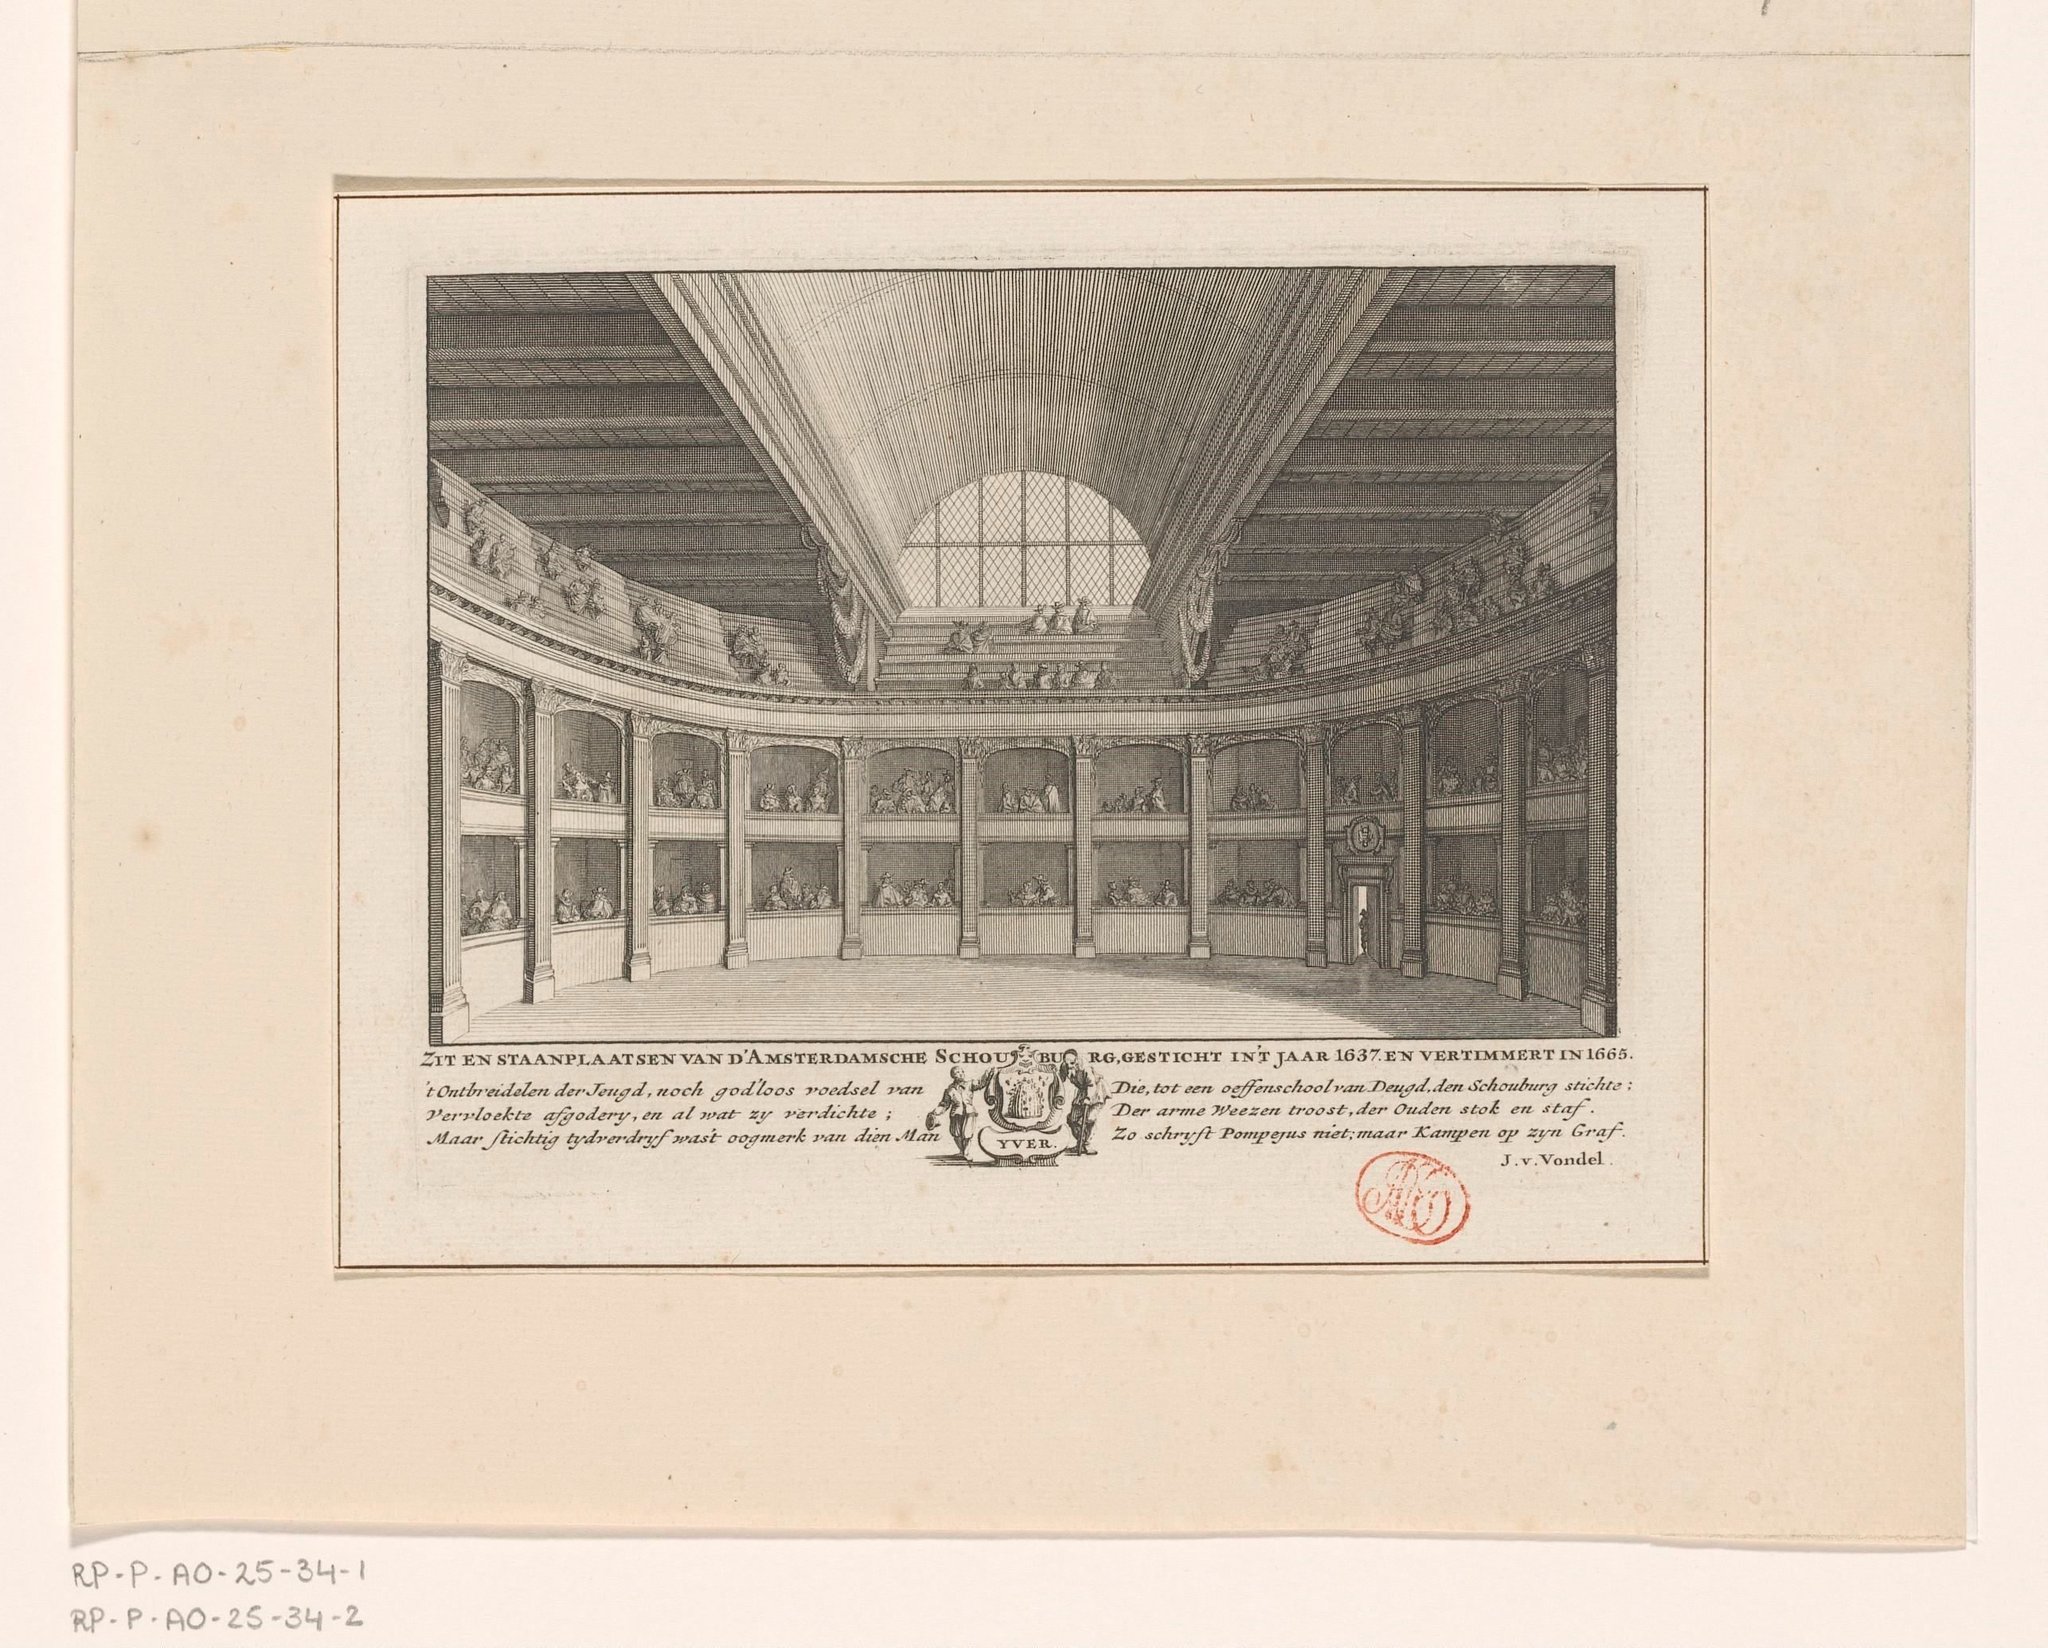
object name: book illustration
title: Zit en staanplaatsen van d'Amsterdamsche Schouburg, gesticht in 't jaar 1637, en vertimmert in 1665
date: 1738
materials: paper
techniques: engraving, etching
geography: amsterdam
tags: boxes, loges ~ theatre, etc., theatre (building)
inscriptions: collector's mark: Lugt 195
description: Prent ook gebruikt in: Marre, Jan de. Het eeuwgetyde van den Amsteldamschen Schouwburg (…). Amsterdam: Isaak Duim, 1738.* En in: Naamen der personaadjen, in het zinnespel het Eeuwgetyde van den Amsteldamschen schouwburg. S.l. [Amsterdam]: s.n., s.a. [1738] [dit is mogelijk een bijlage van de eerst genoemde publicatie]. * Niet elk exemplaar van deze publicatie bevat prenten. Zie ook RP-P-OB-79.417, RP-P-OB-81.422, RP-P-OB-81.423, RP-P-AO-25-32, RP-P-AO-25-34-1 en RP-P-AO-25-35.